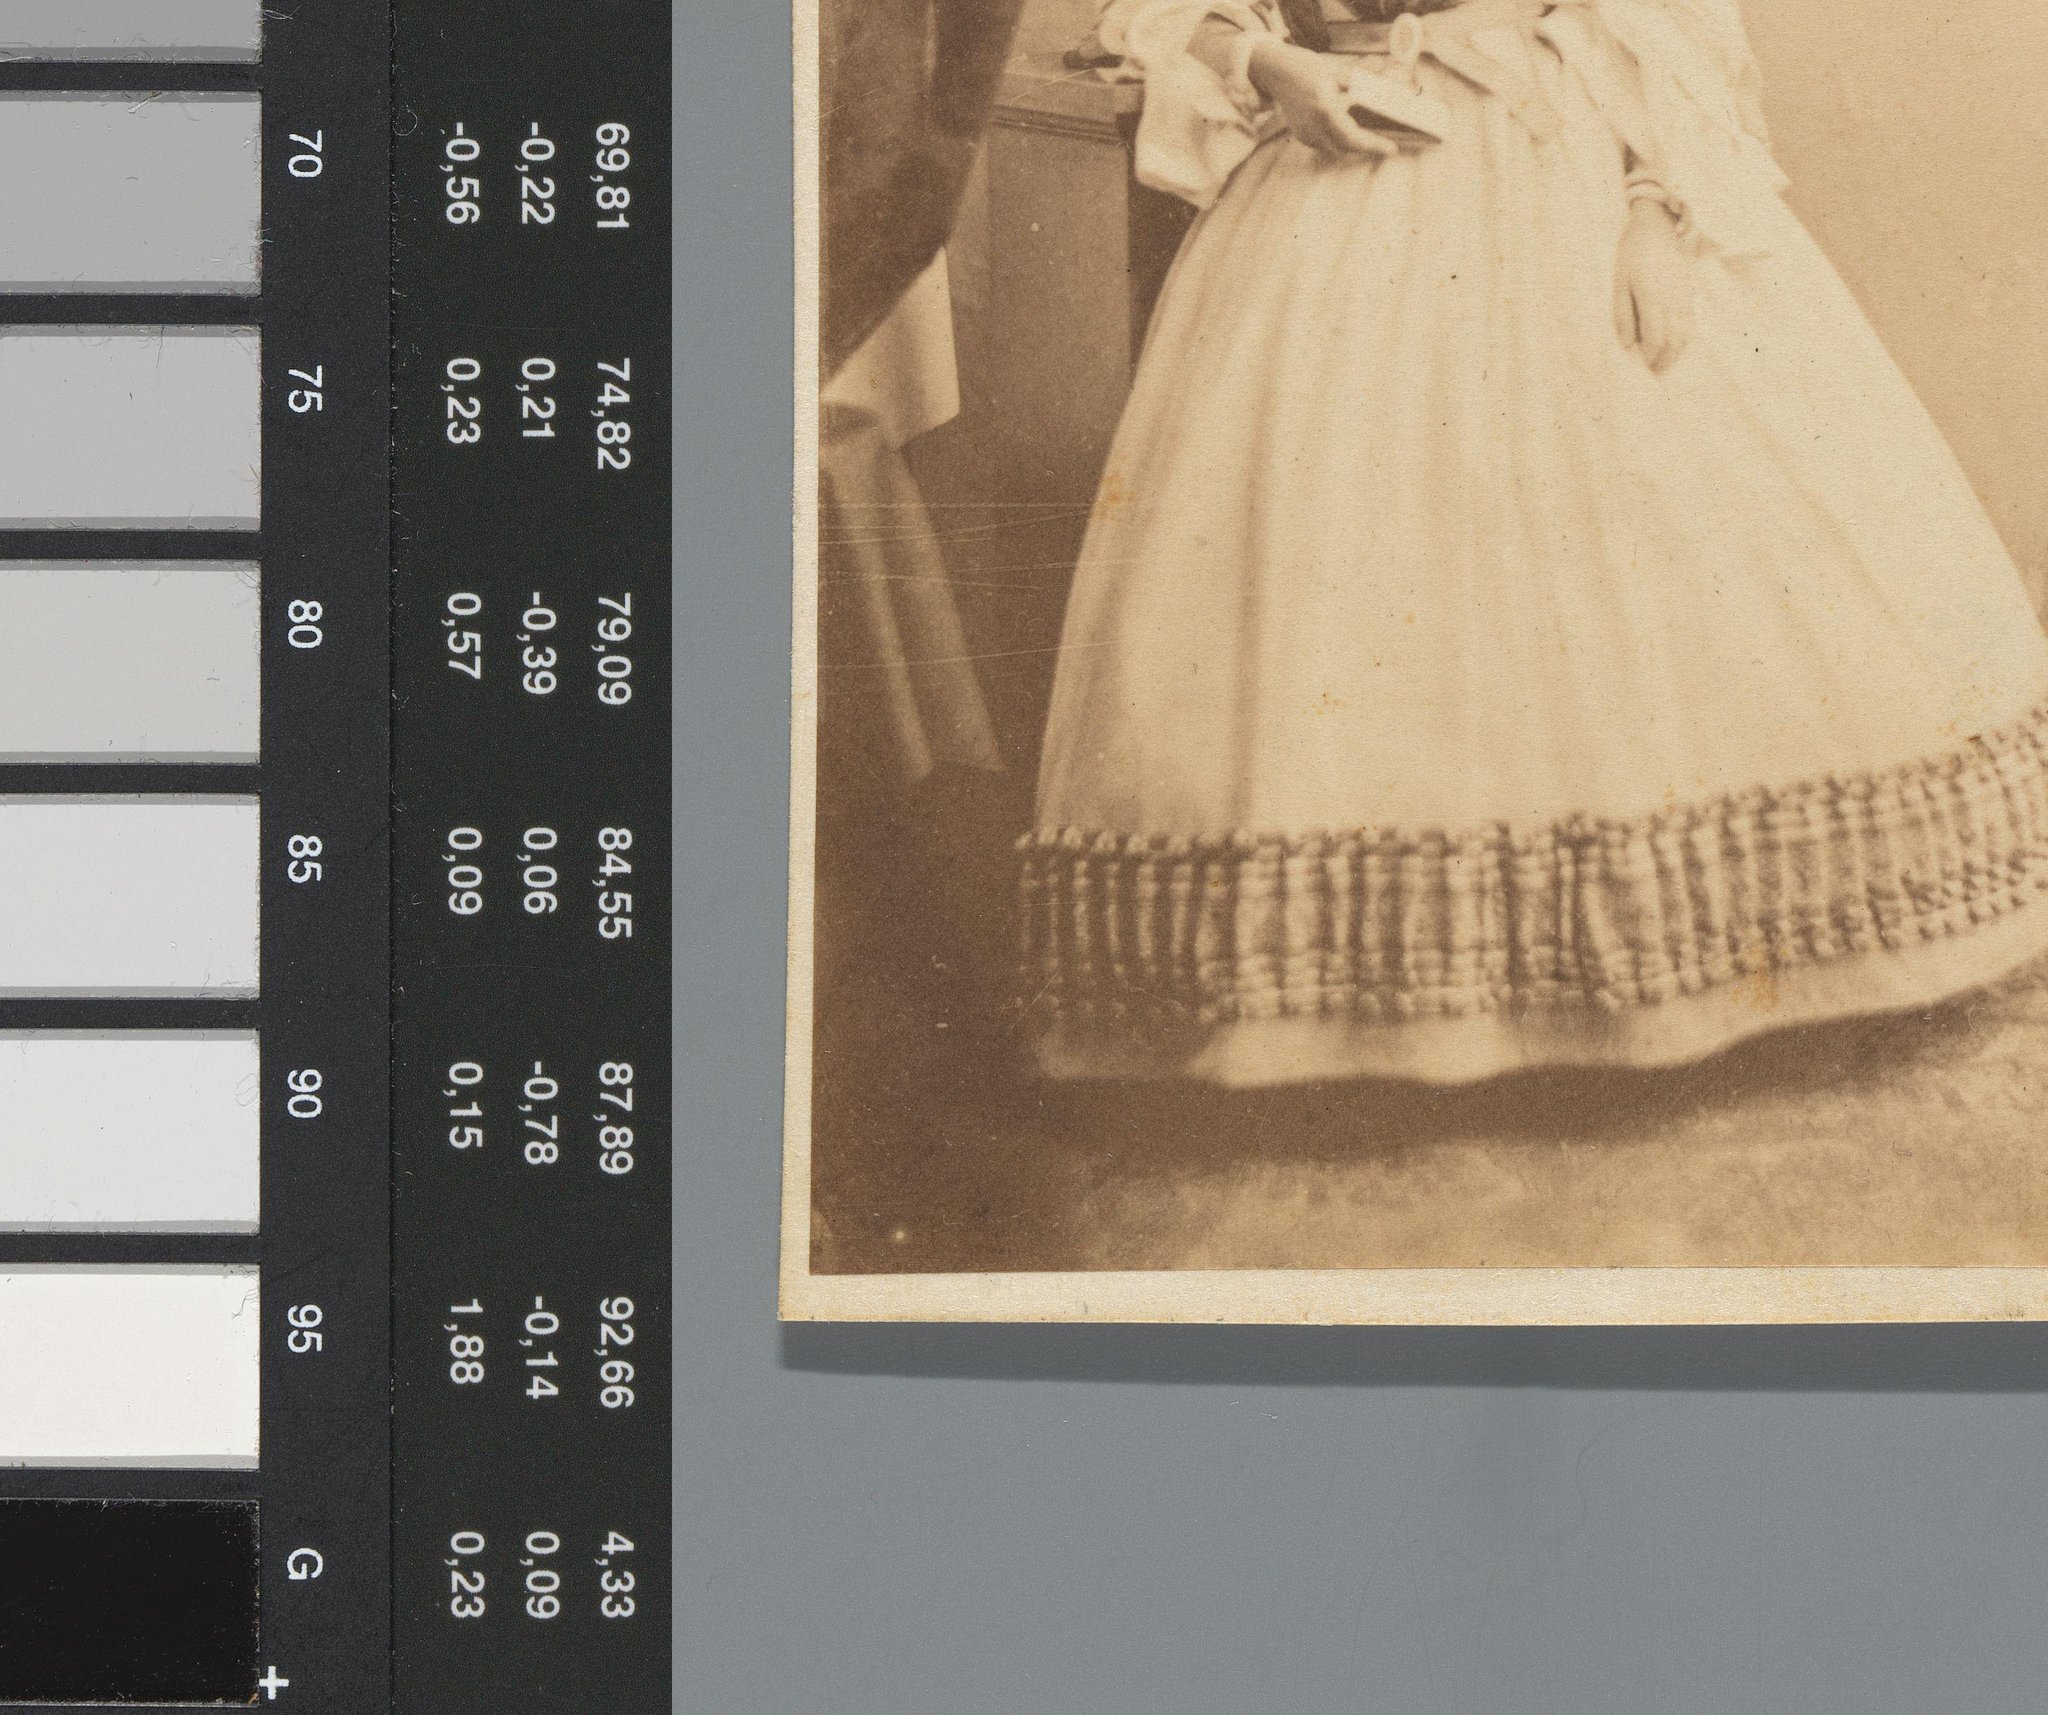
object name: photograph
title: Portret van Joanna Emilia Agnes van den Berg (Jeanette)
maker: Anonymous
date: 1855-1910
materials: cardboard, photographic support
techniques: albumen print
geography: netherlands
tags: the hague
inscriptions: inscription: ‘Jeanette / Trip - vd B’